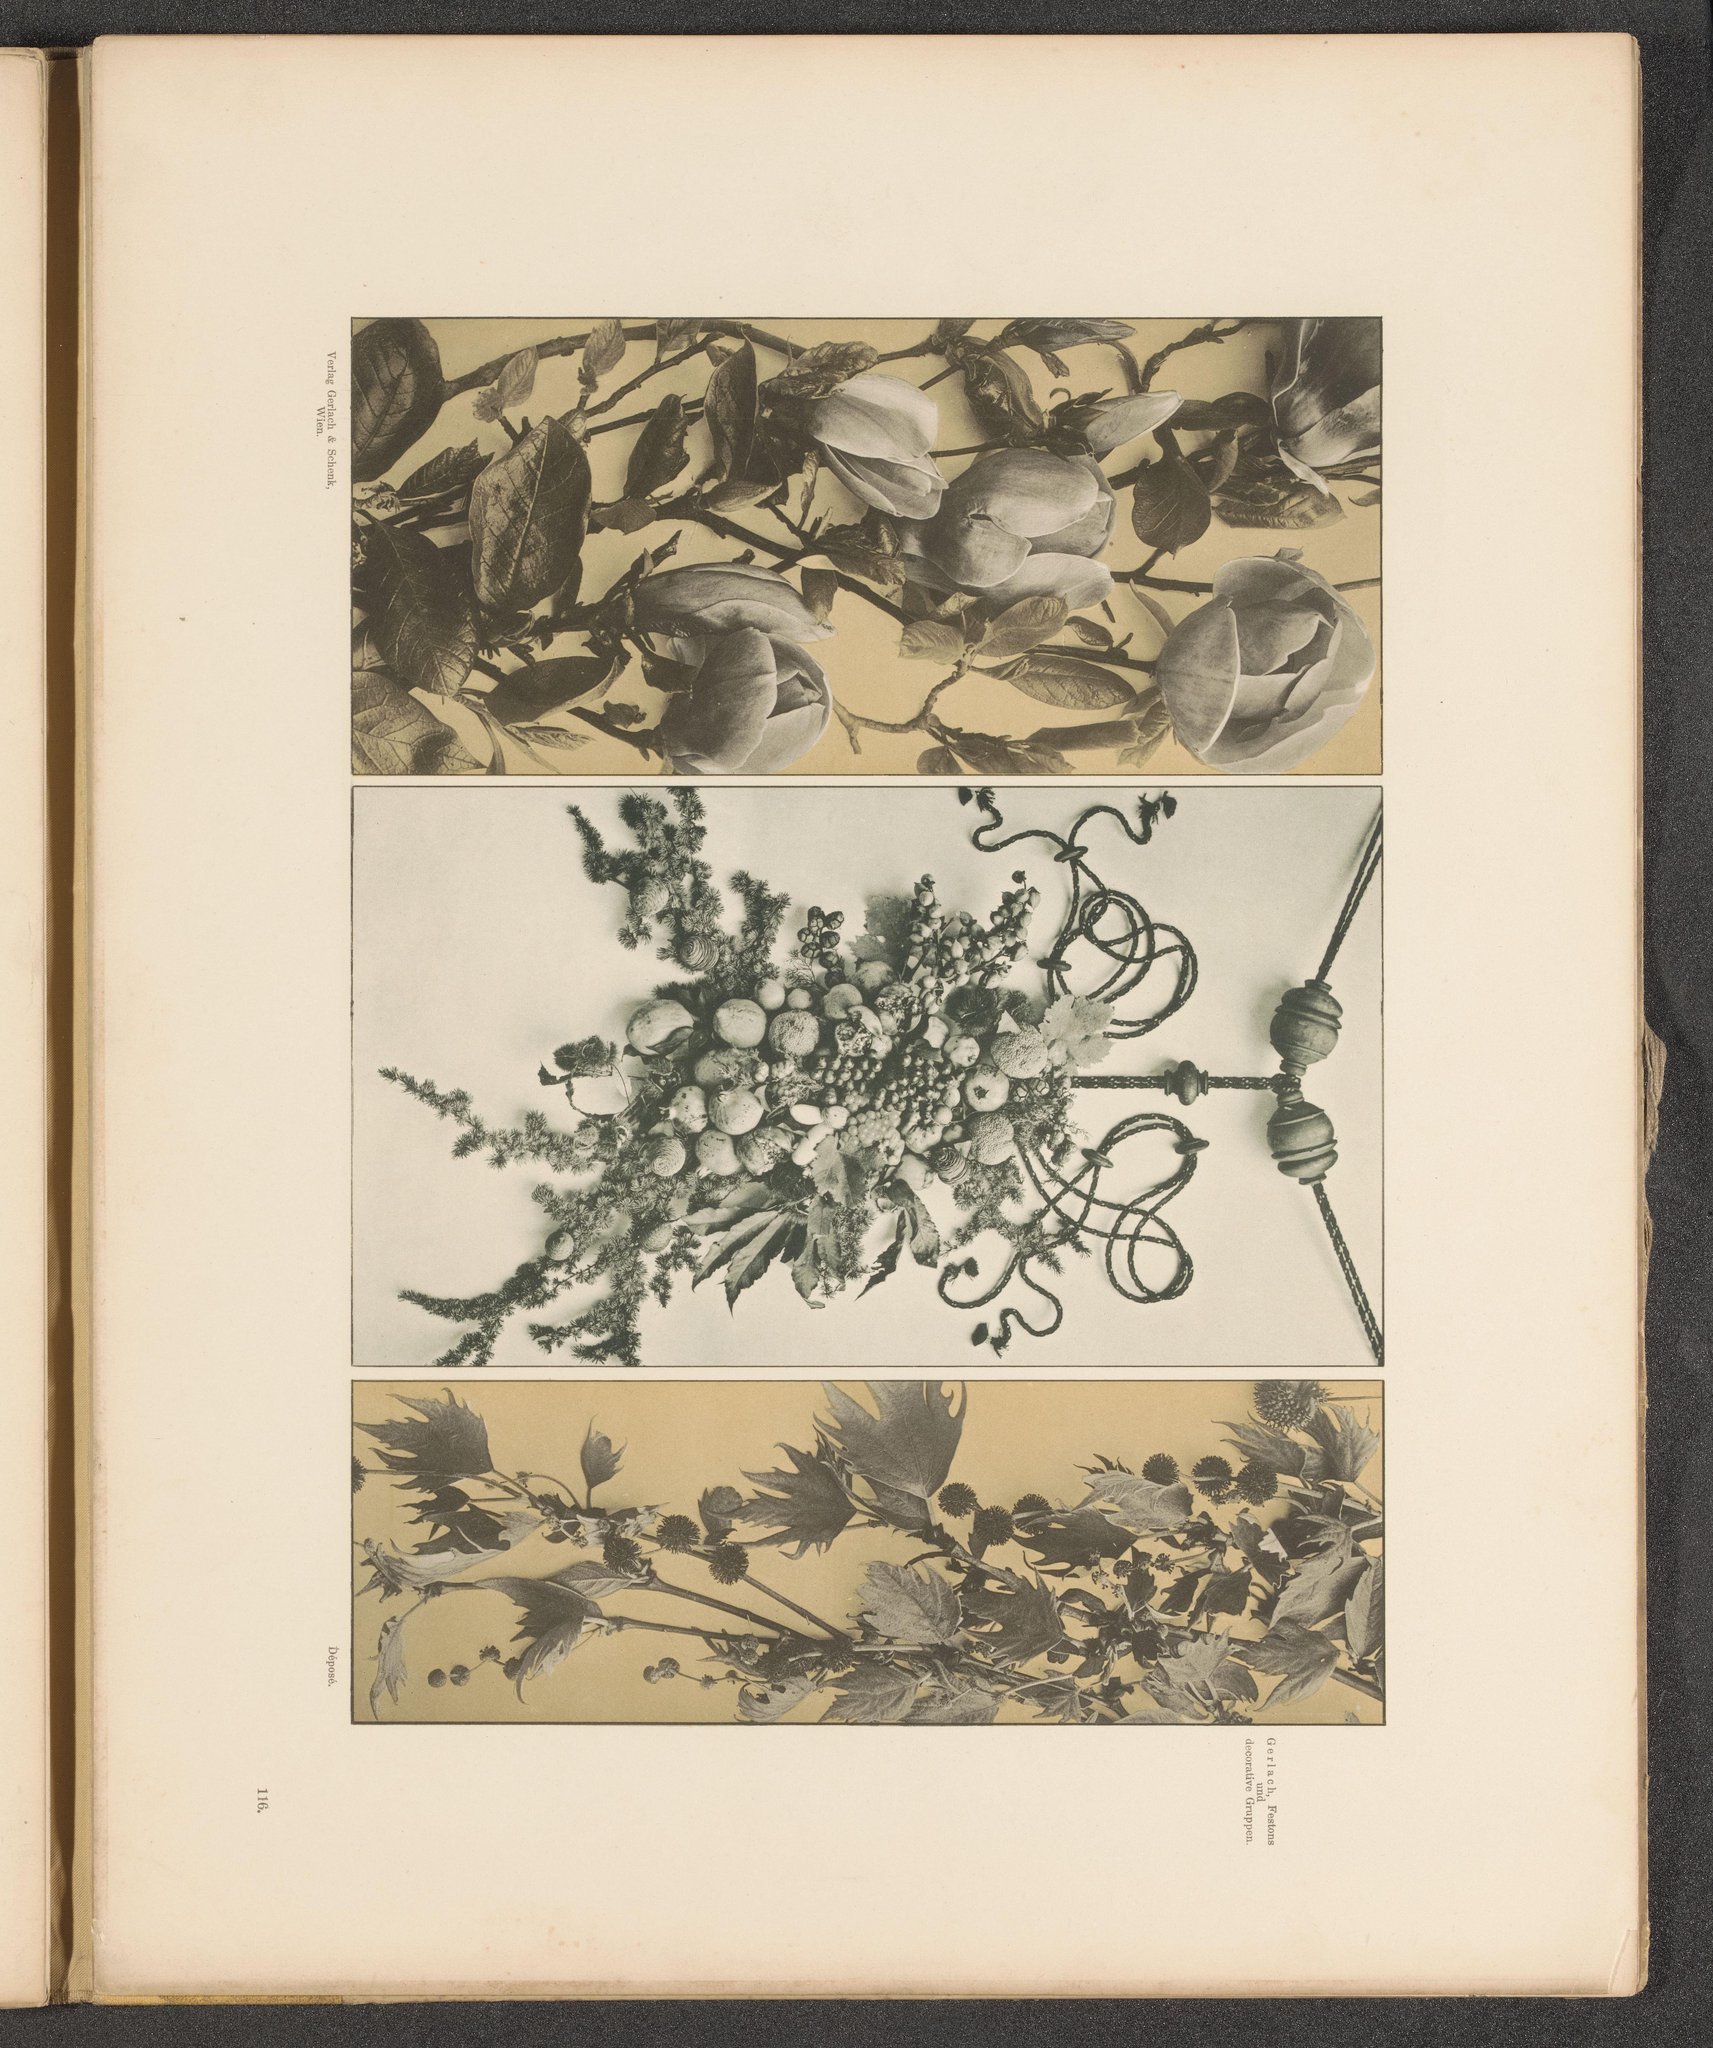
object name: page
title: Drie vlakken met tulpen, plataan en een festoen met fruit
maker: Anonymous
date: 1887-1897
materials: paper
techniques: photograph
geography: vienna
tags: flowers: tulip, ornament ~ festoon, garland, fruits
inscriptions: number: ‘116.’